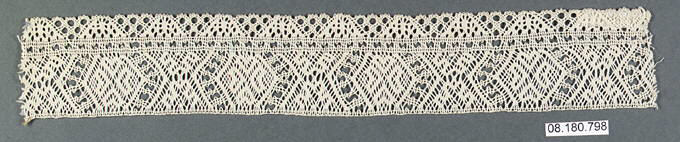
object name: insertion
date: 1801-1900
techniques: lace